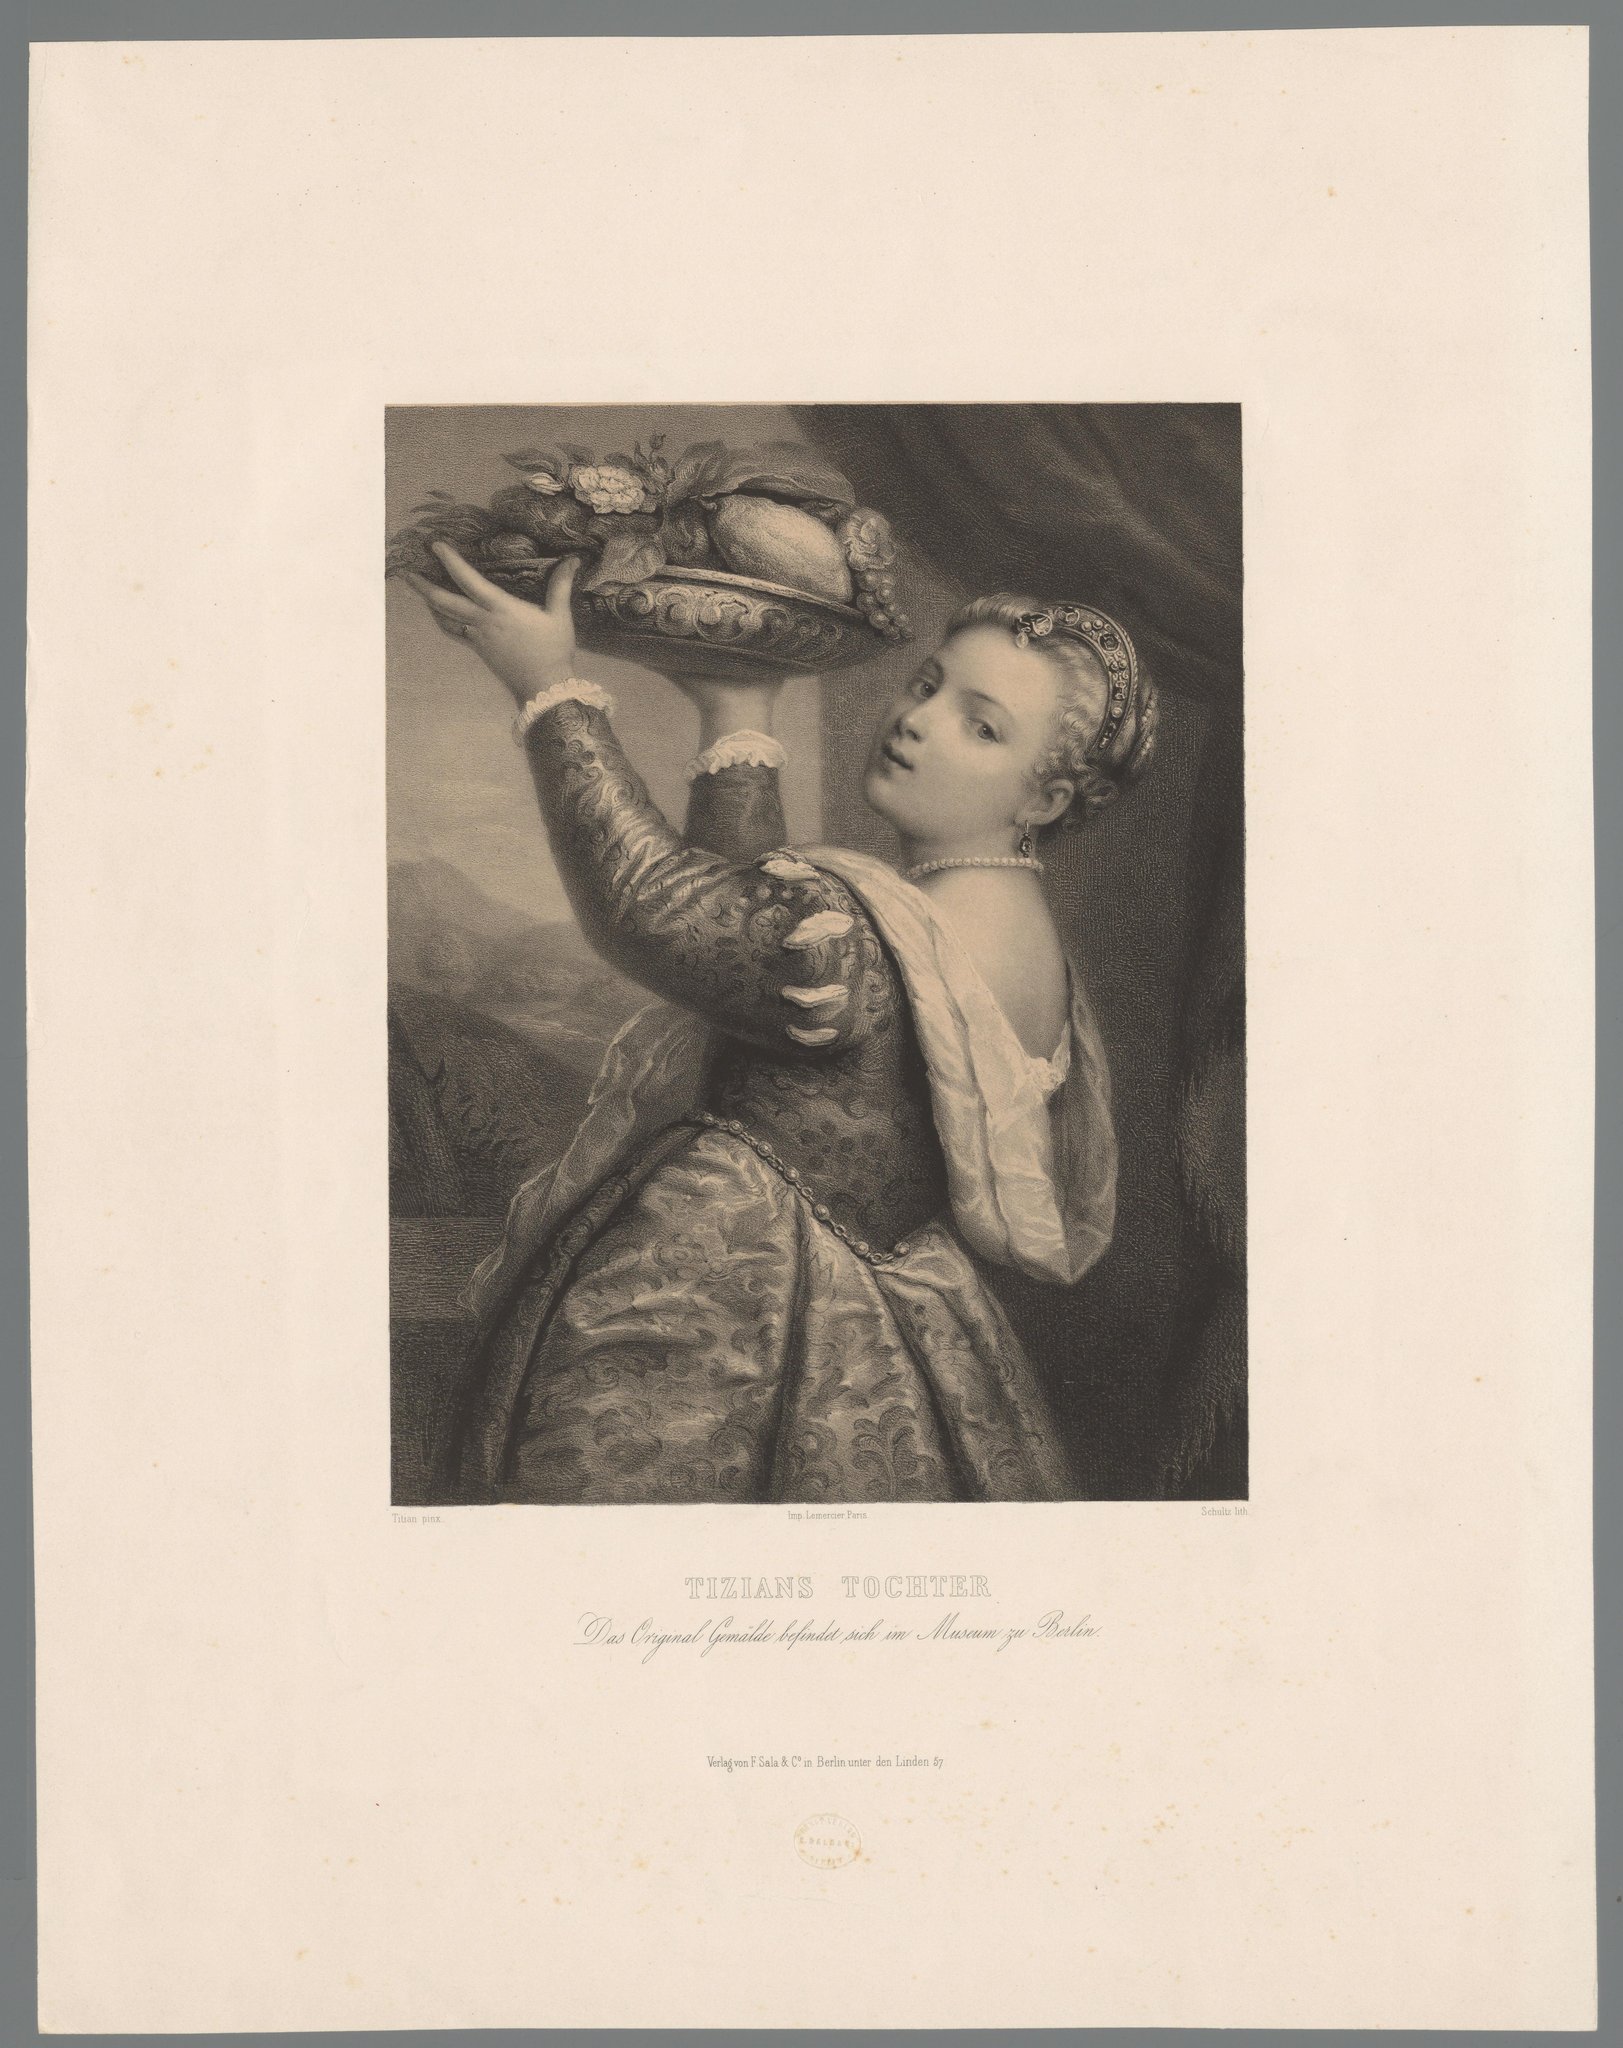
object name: print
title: Meisje met een schaal vruchten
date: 1828-1887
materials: paper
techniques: lithograph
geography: paris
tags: adolescent, young woman, maiden, fruits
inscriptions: collector's mark: Lugt 2228, check stamp: ‘Kunst-Verlag F. Sala & Co Berlin’